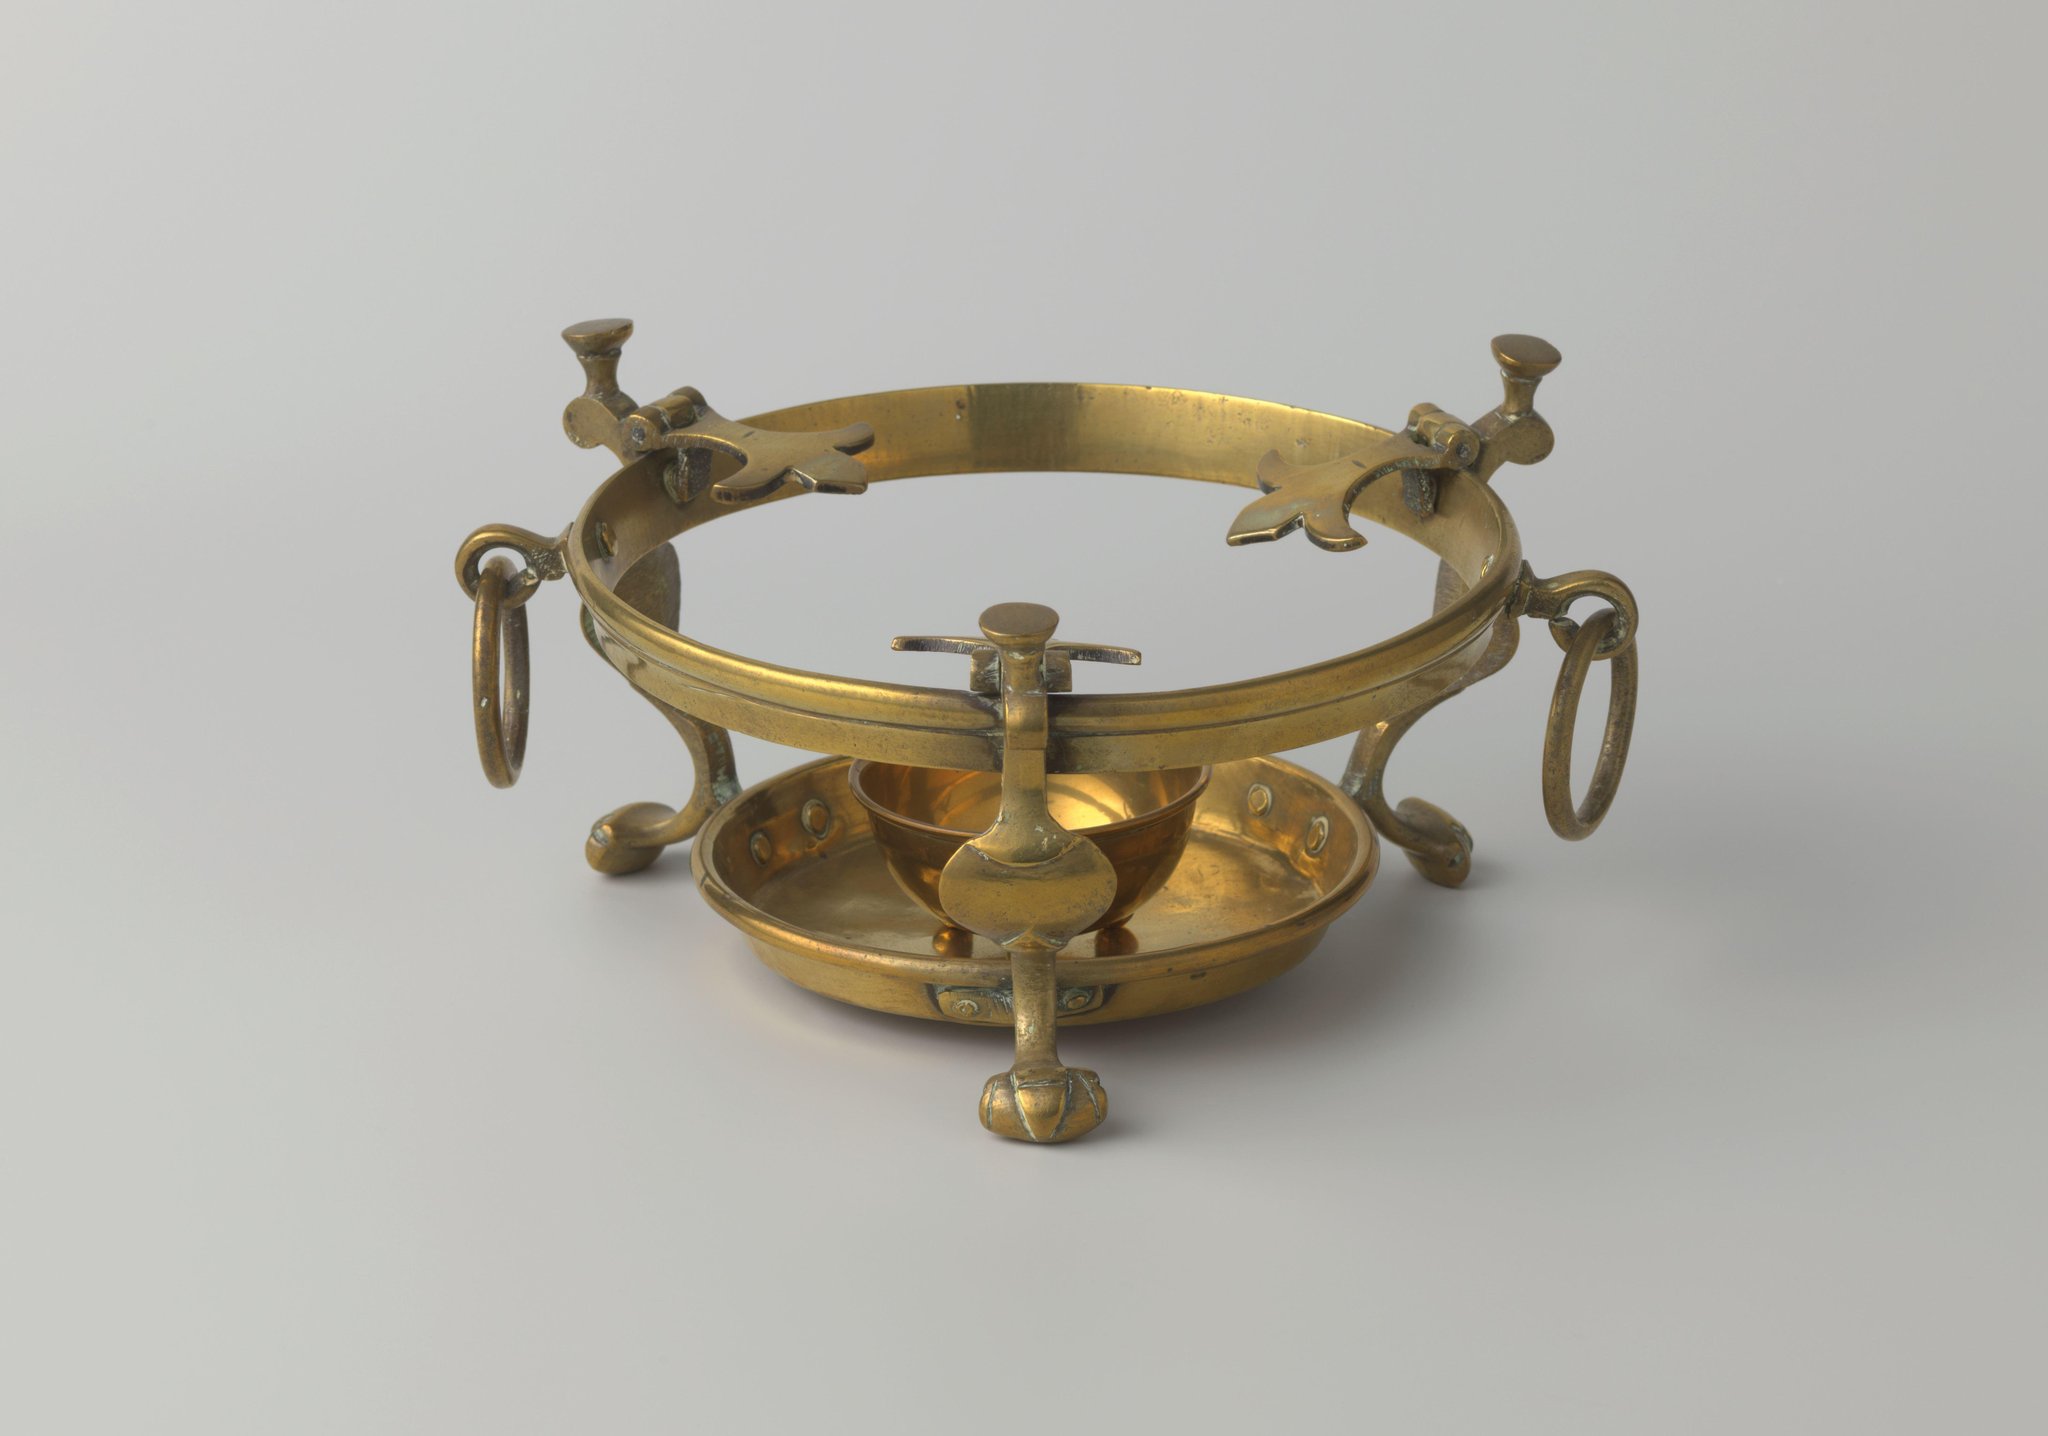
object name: komfoor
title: Komfoor van messing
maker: Anonymous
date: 1700-1725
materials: brass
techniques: casting, riveted, turning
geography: netherlands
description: Het voorwerp bestaat uit de volgende gegoten of uit plaat gedraaide, vervolgens geklonken onderdelen: de in- en uitgezwenkte verbindingsdelen op klauwpoten en met knoppen bovenop, een bakje en de geprofileerde ring. Aan de verbindingsdelen zijn opklapbare zetstukken in de vorm van een Franse lelie scharnierend gemonteerd. Aan de geprofileerde ring zijn twee ogen geklonken, waaraan ringen zijn bevestigd, waarmee het voorwerp kan worden opgenomen.